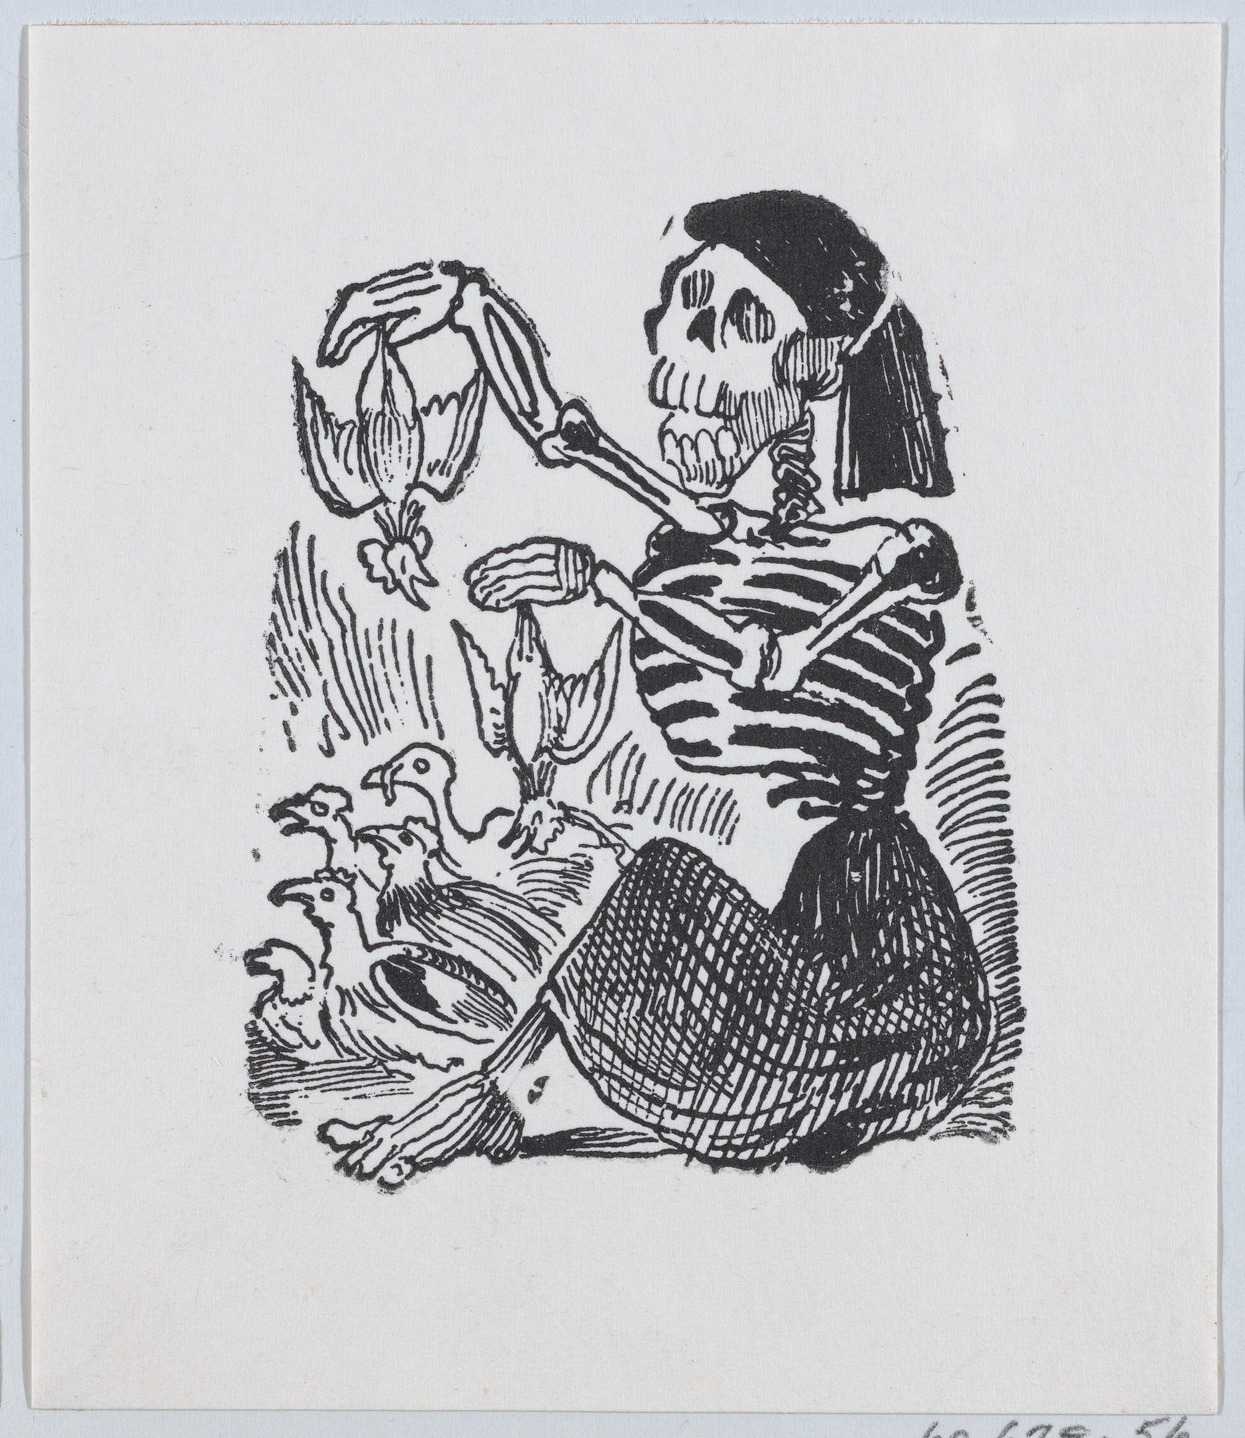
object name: print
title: A skeleton selling plucked chickens from a broadside entitled 'Una Calavera Chusca'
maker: josé guadalupe posada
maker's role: artist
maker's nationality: mexican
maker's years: 1852-1913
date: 1880-1910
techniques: lithography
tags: chickens,skeletons